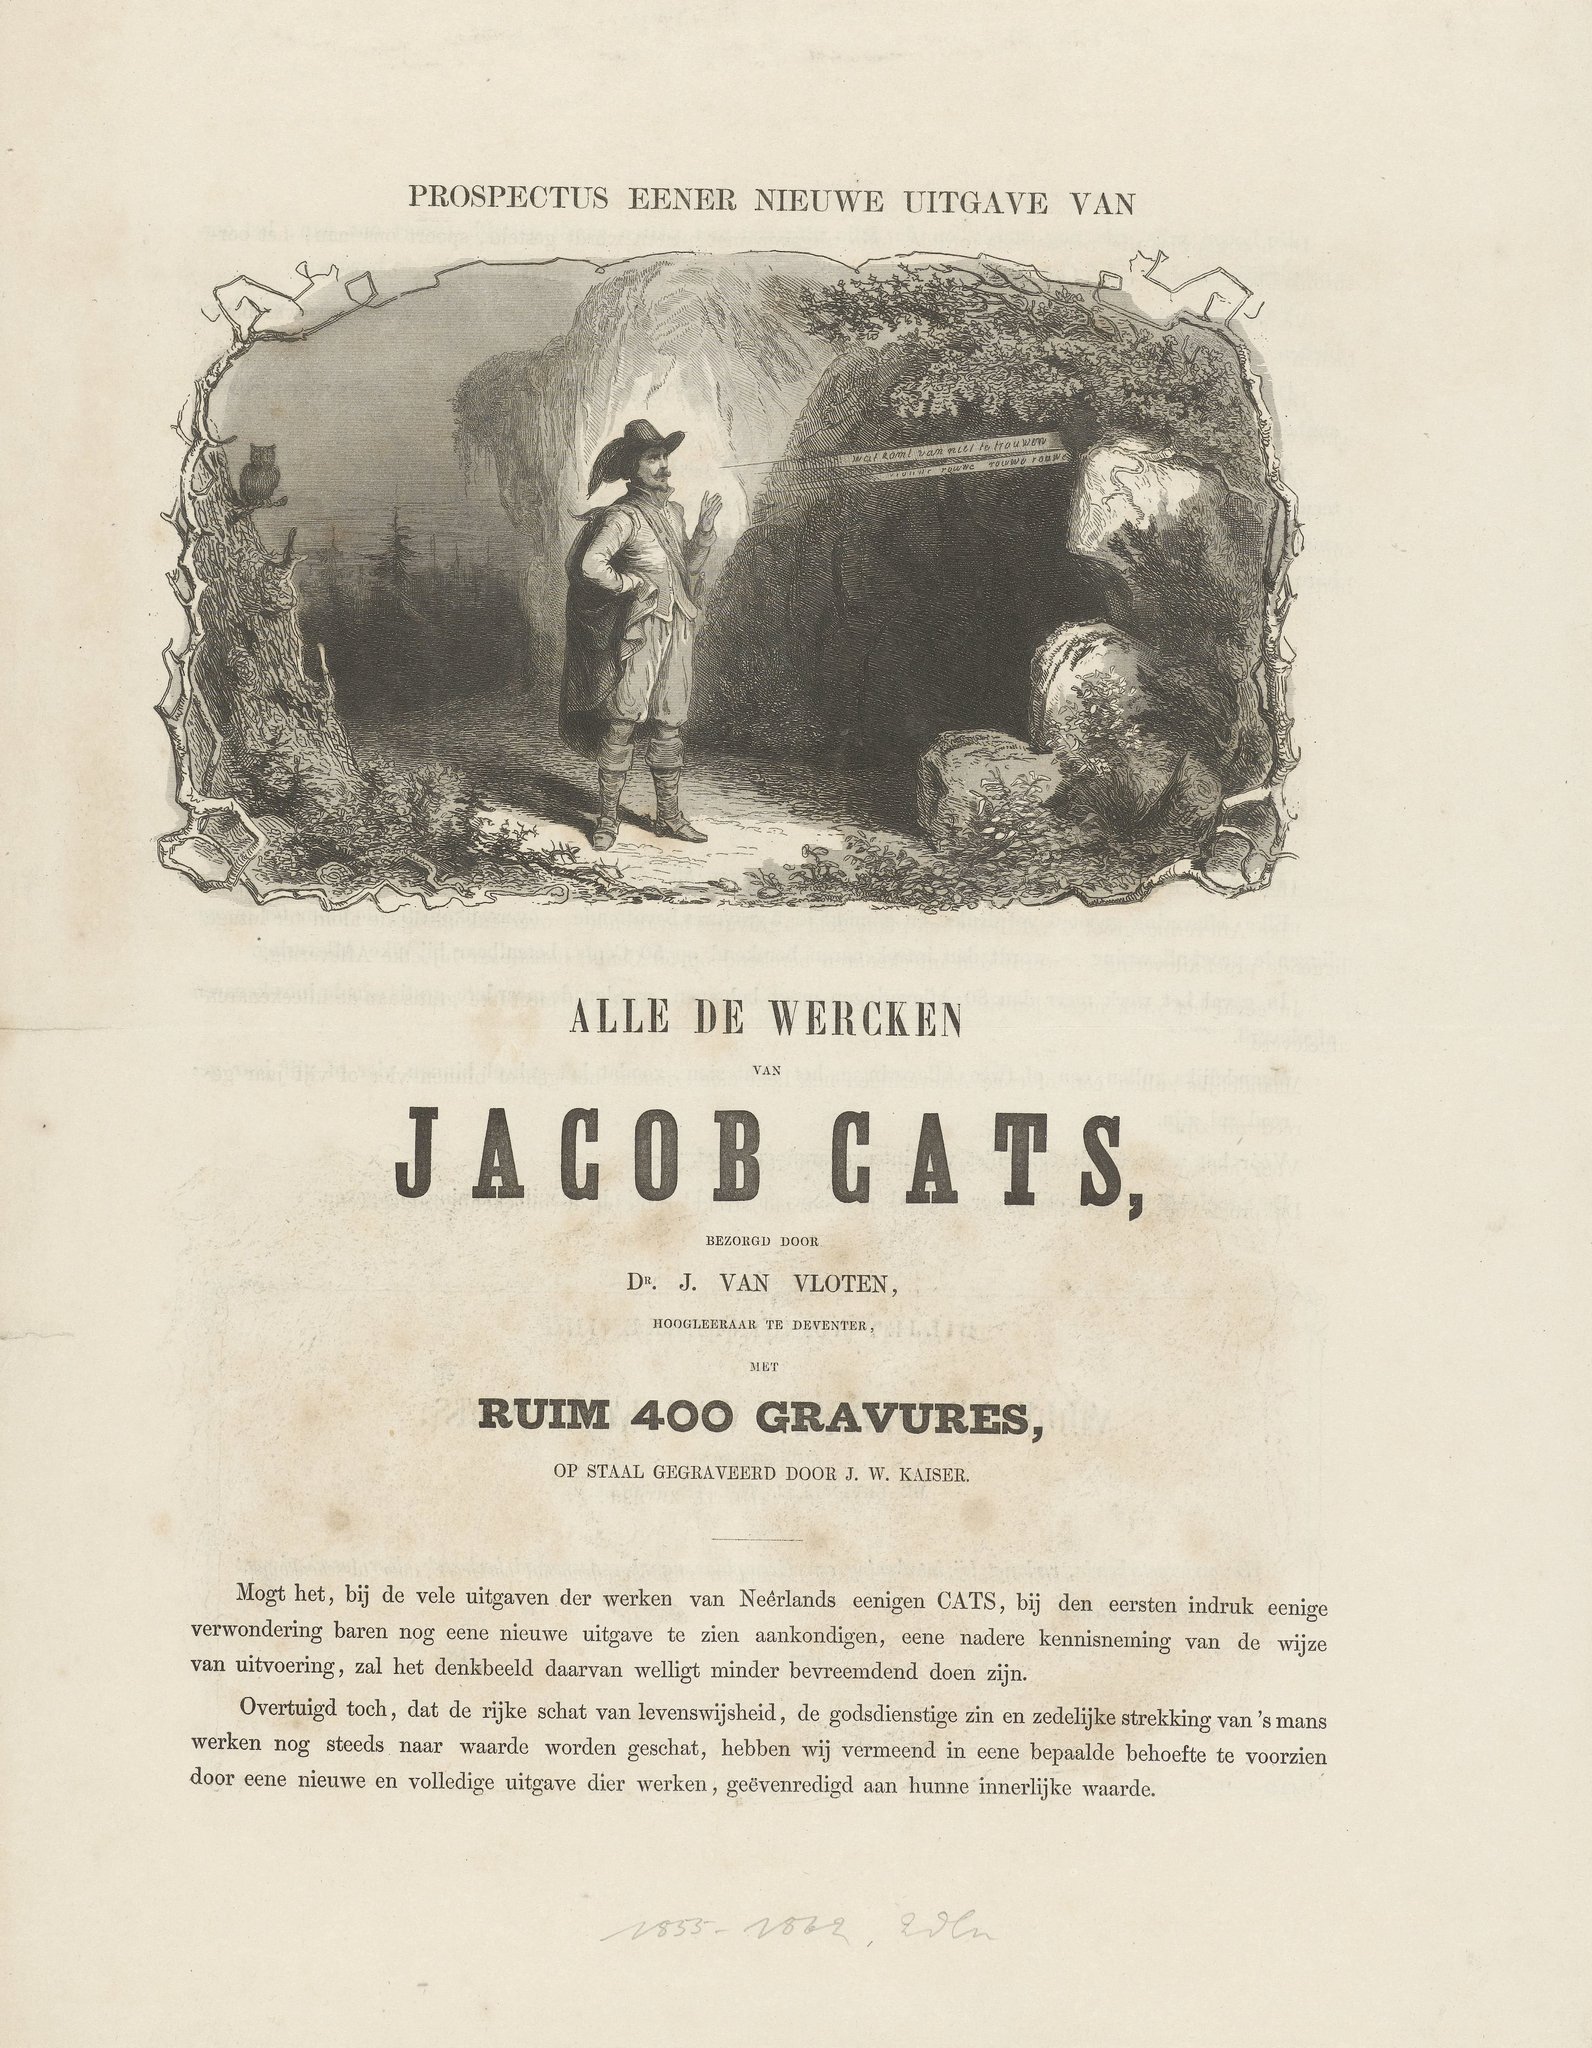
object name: titelblad, titelpagina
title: Titelpagina voor de prospectus van alle wercken van Jacob Cats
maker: johann wilhelm kaiser (i)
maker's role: draughtsman, print maker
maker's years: 1813-1900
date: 1855-1862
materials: paper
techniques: engraving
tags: jacob cats (1577-1660)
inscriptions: collector's mark: Lugt 2228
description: Titelpagina voor de prospectus van de nieuwe uitgave van alle werken van Jacob Cats. Op de afbeelding staat Jacob Cats tegenover een grot waar twee stroken met tekst bij staan: wat komt van niet te trouwen, vrouwe rouwe rouwe rouwe. Onder de afbeelding de titel van het boek en daaronder een zesregelige tekst.